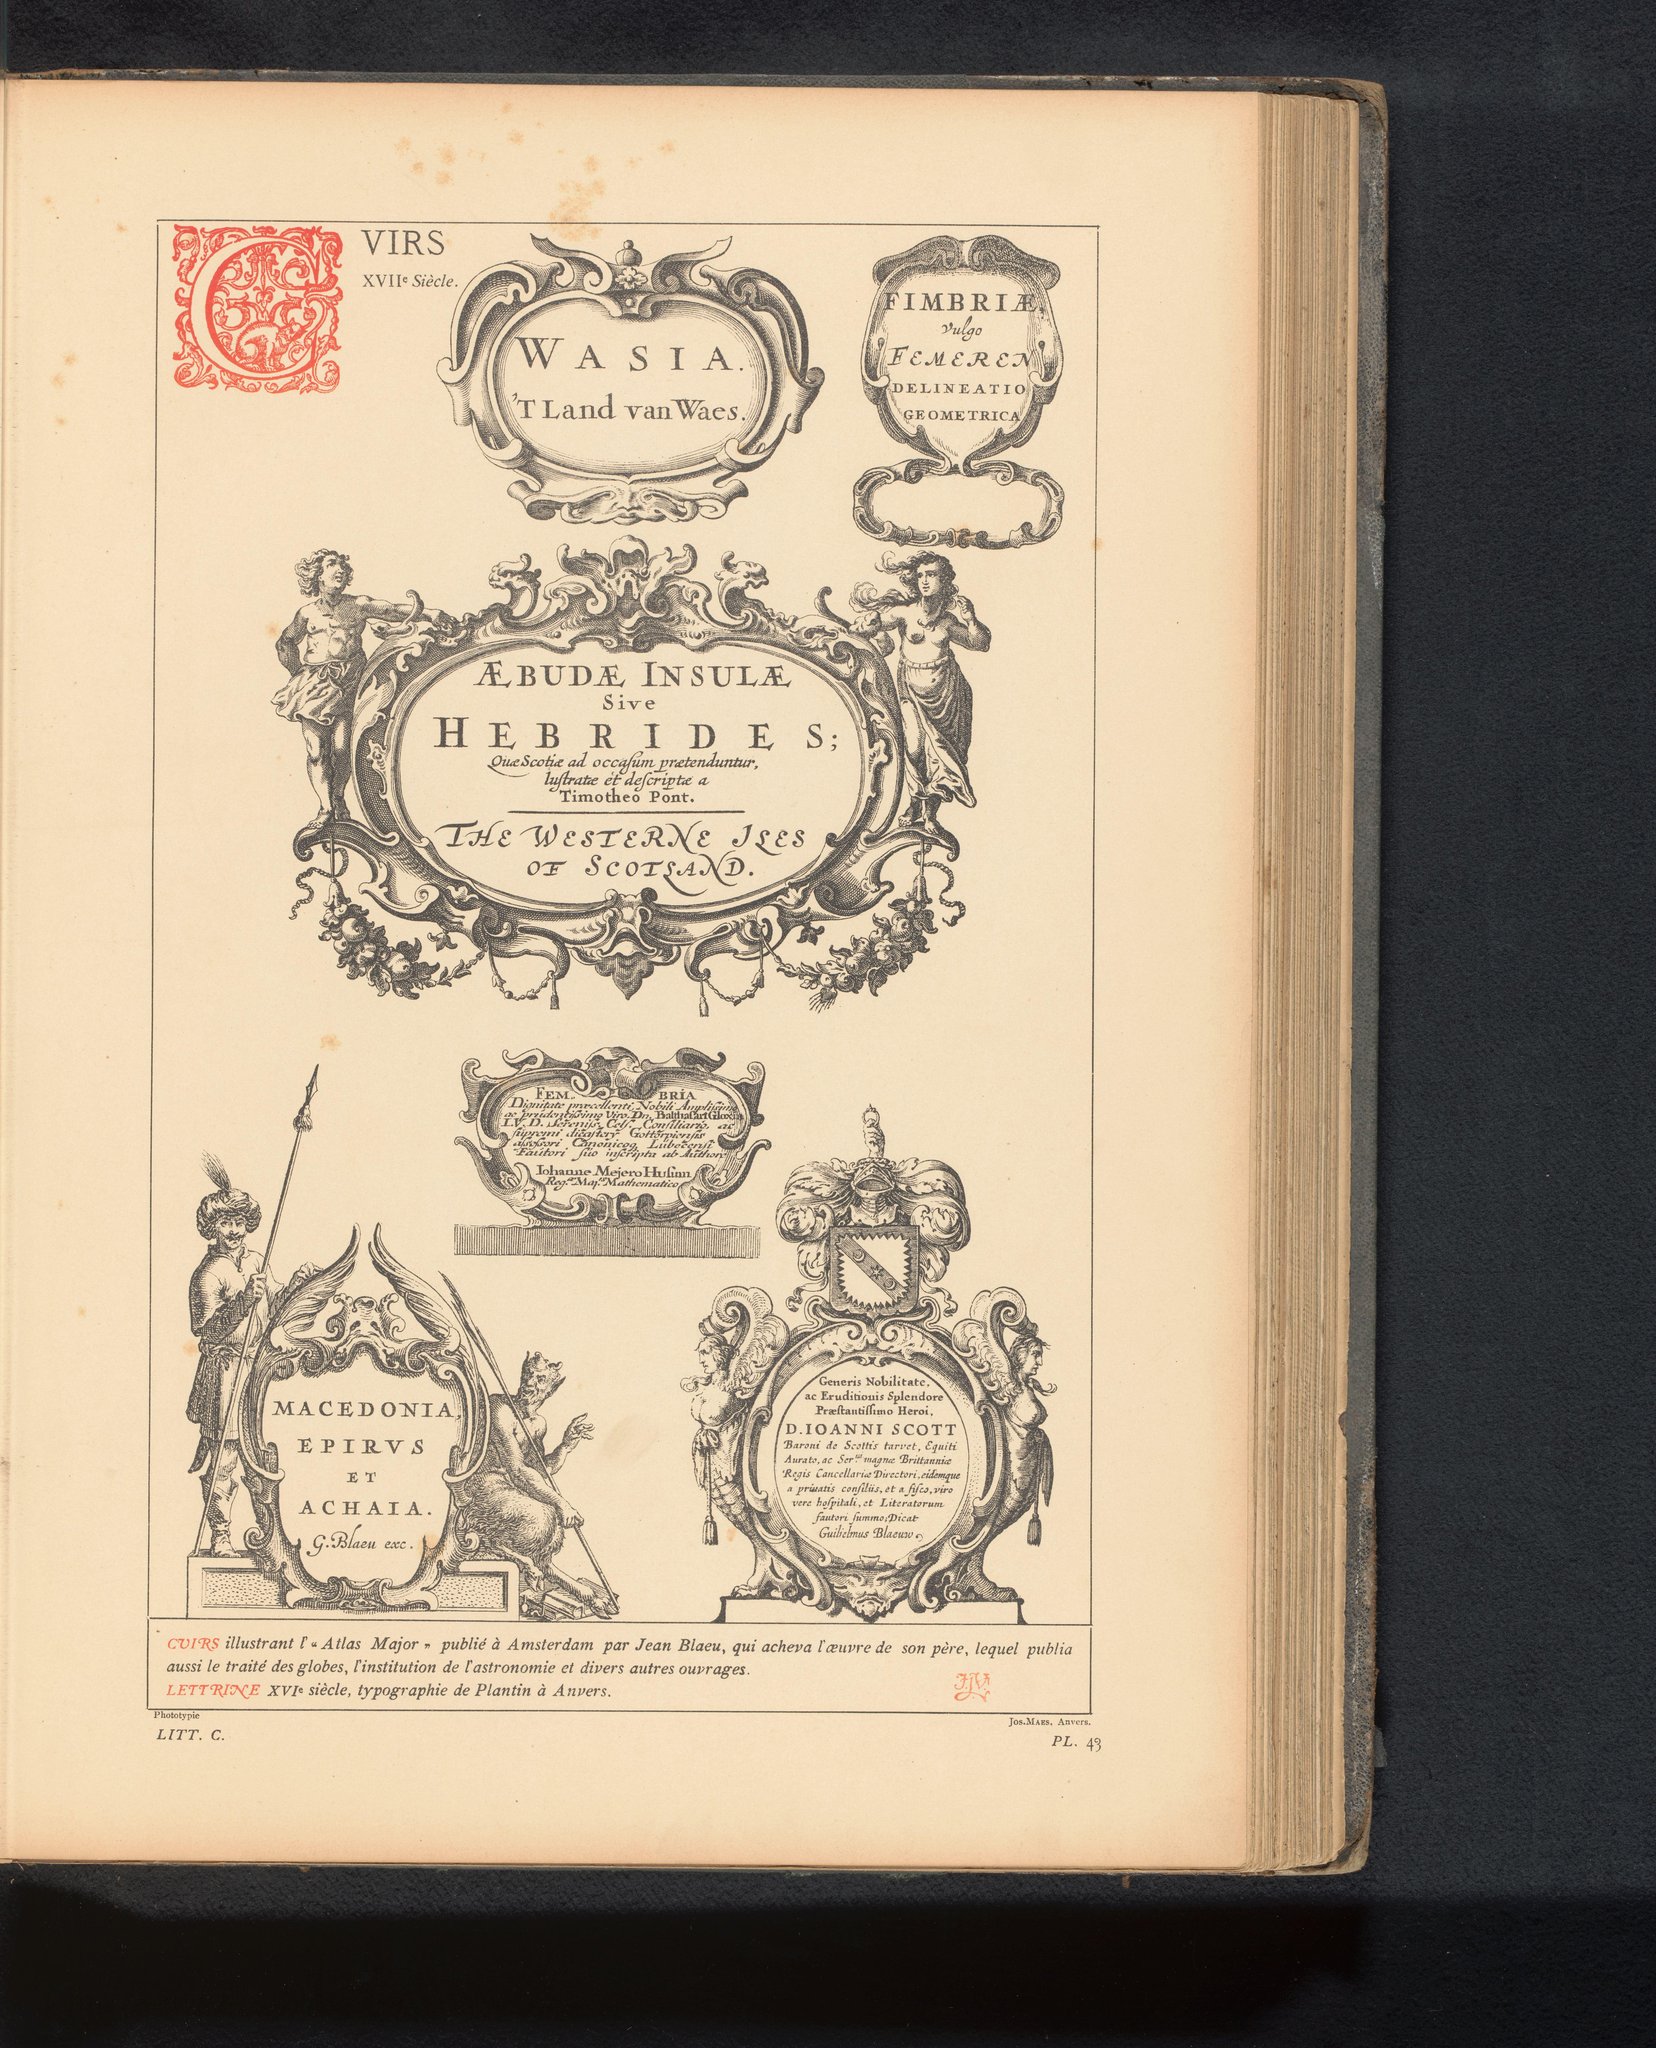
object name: reproduction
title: Cuirs, XVIIe Siècle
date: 1875-1880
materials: paper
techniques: photolithography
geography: antwerp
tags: ornament ~ cartouche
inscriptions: inscription: ‘Cuirs illustrant l'Atlas Major (...)’, inscription: ‘LITT: C. - PL. 43’, monogram: ‘JJvY’